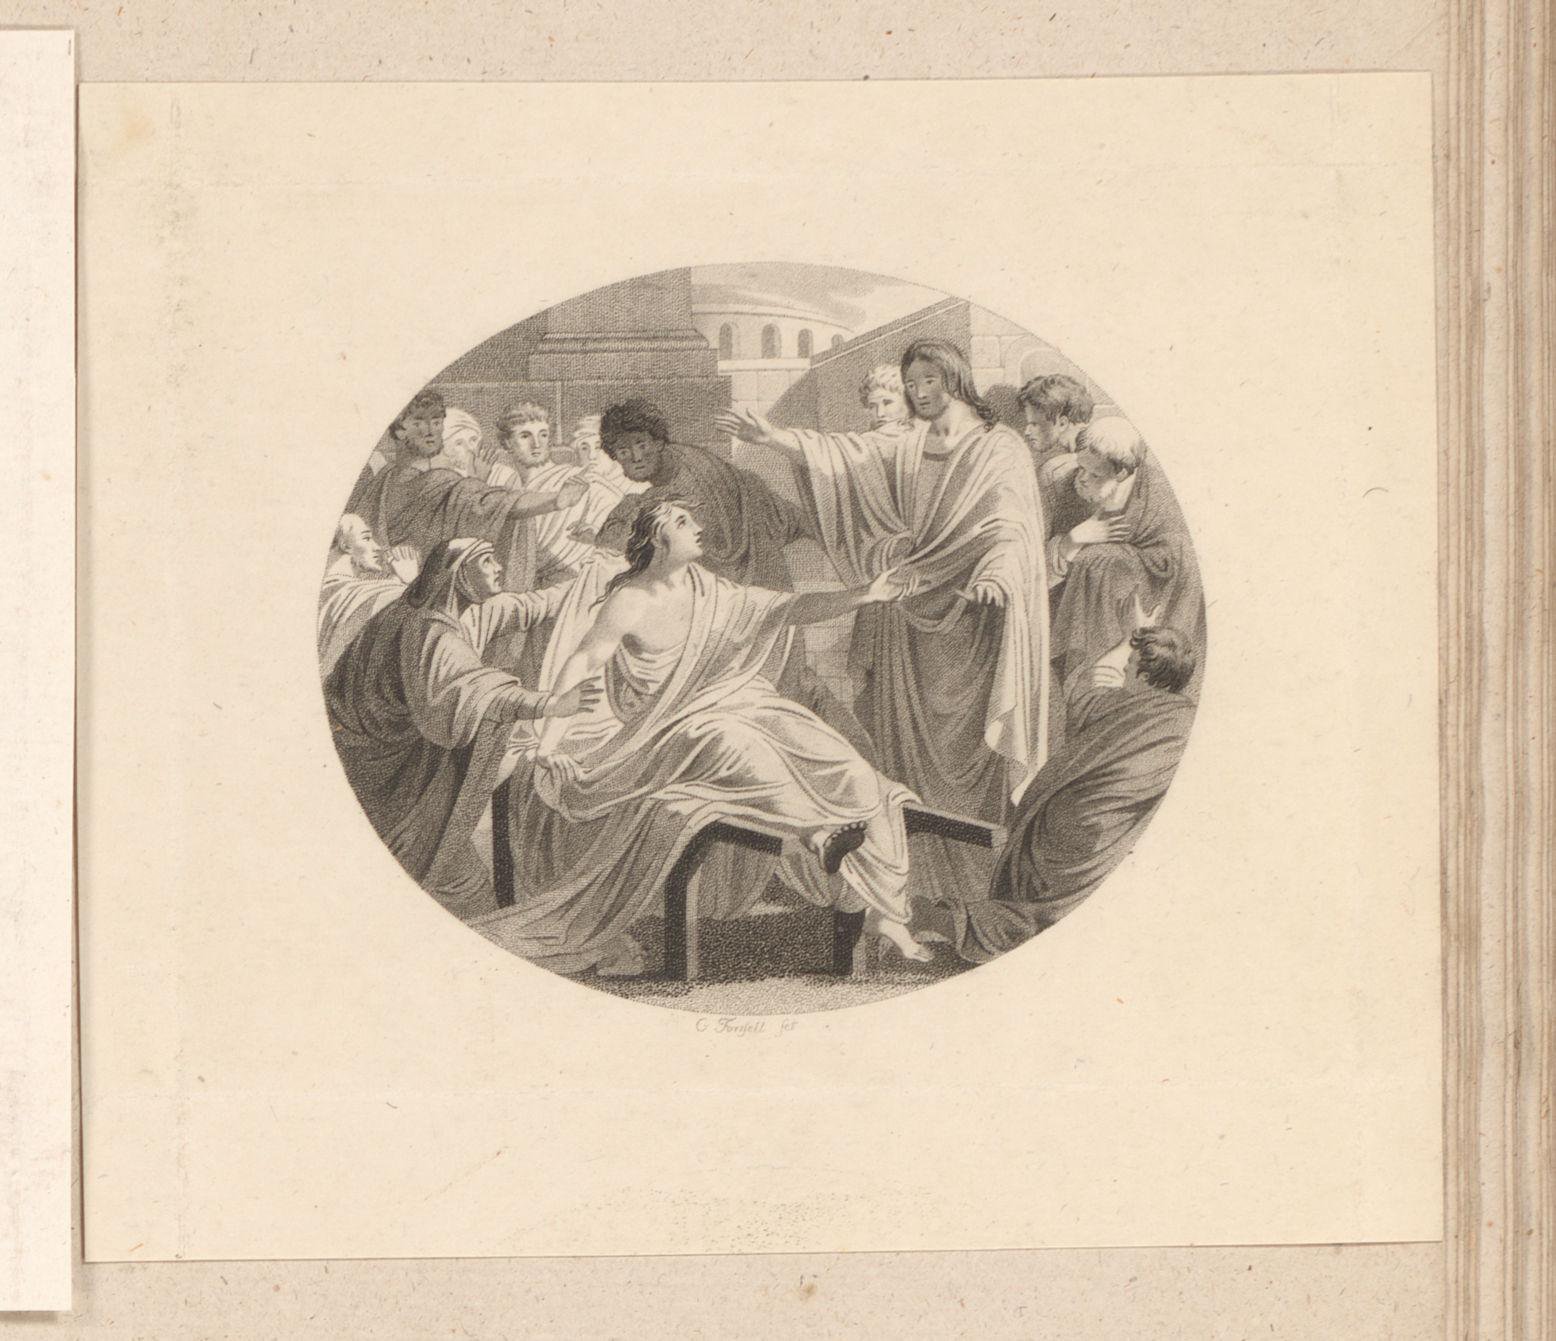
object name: album leaf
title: Opstanding van Semida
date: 1804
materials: paper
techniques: engraving, etching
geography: haarlem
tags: raising from the dead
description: Gebruikt als boekillustratie in: Adriaan Pietersz. Loosjes. Semida en Cidli of de Hope der opstanding. Haarlem: A. Loosjes, 1804. Heruitgegeven in 1816.